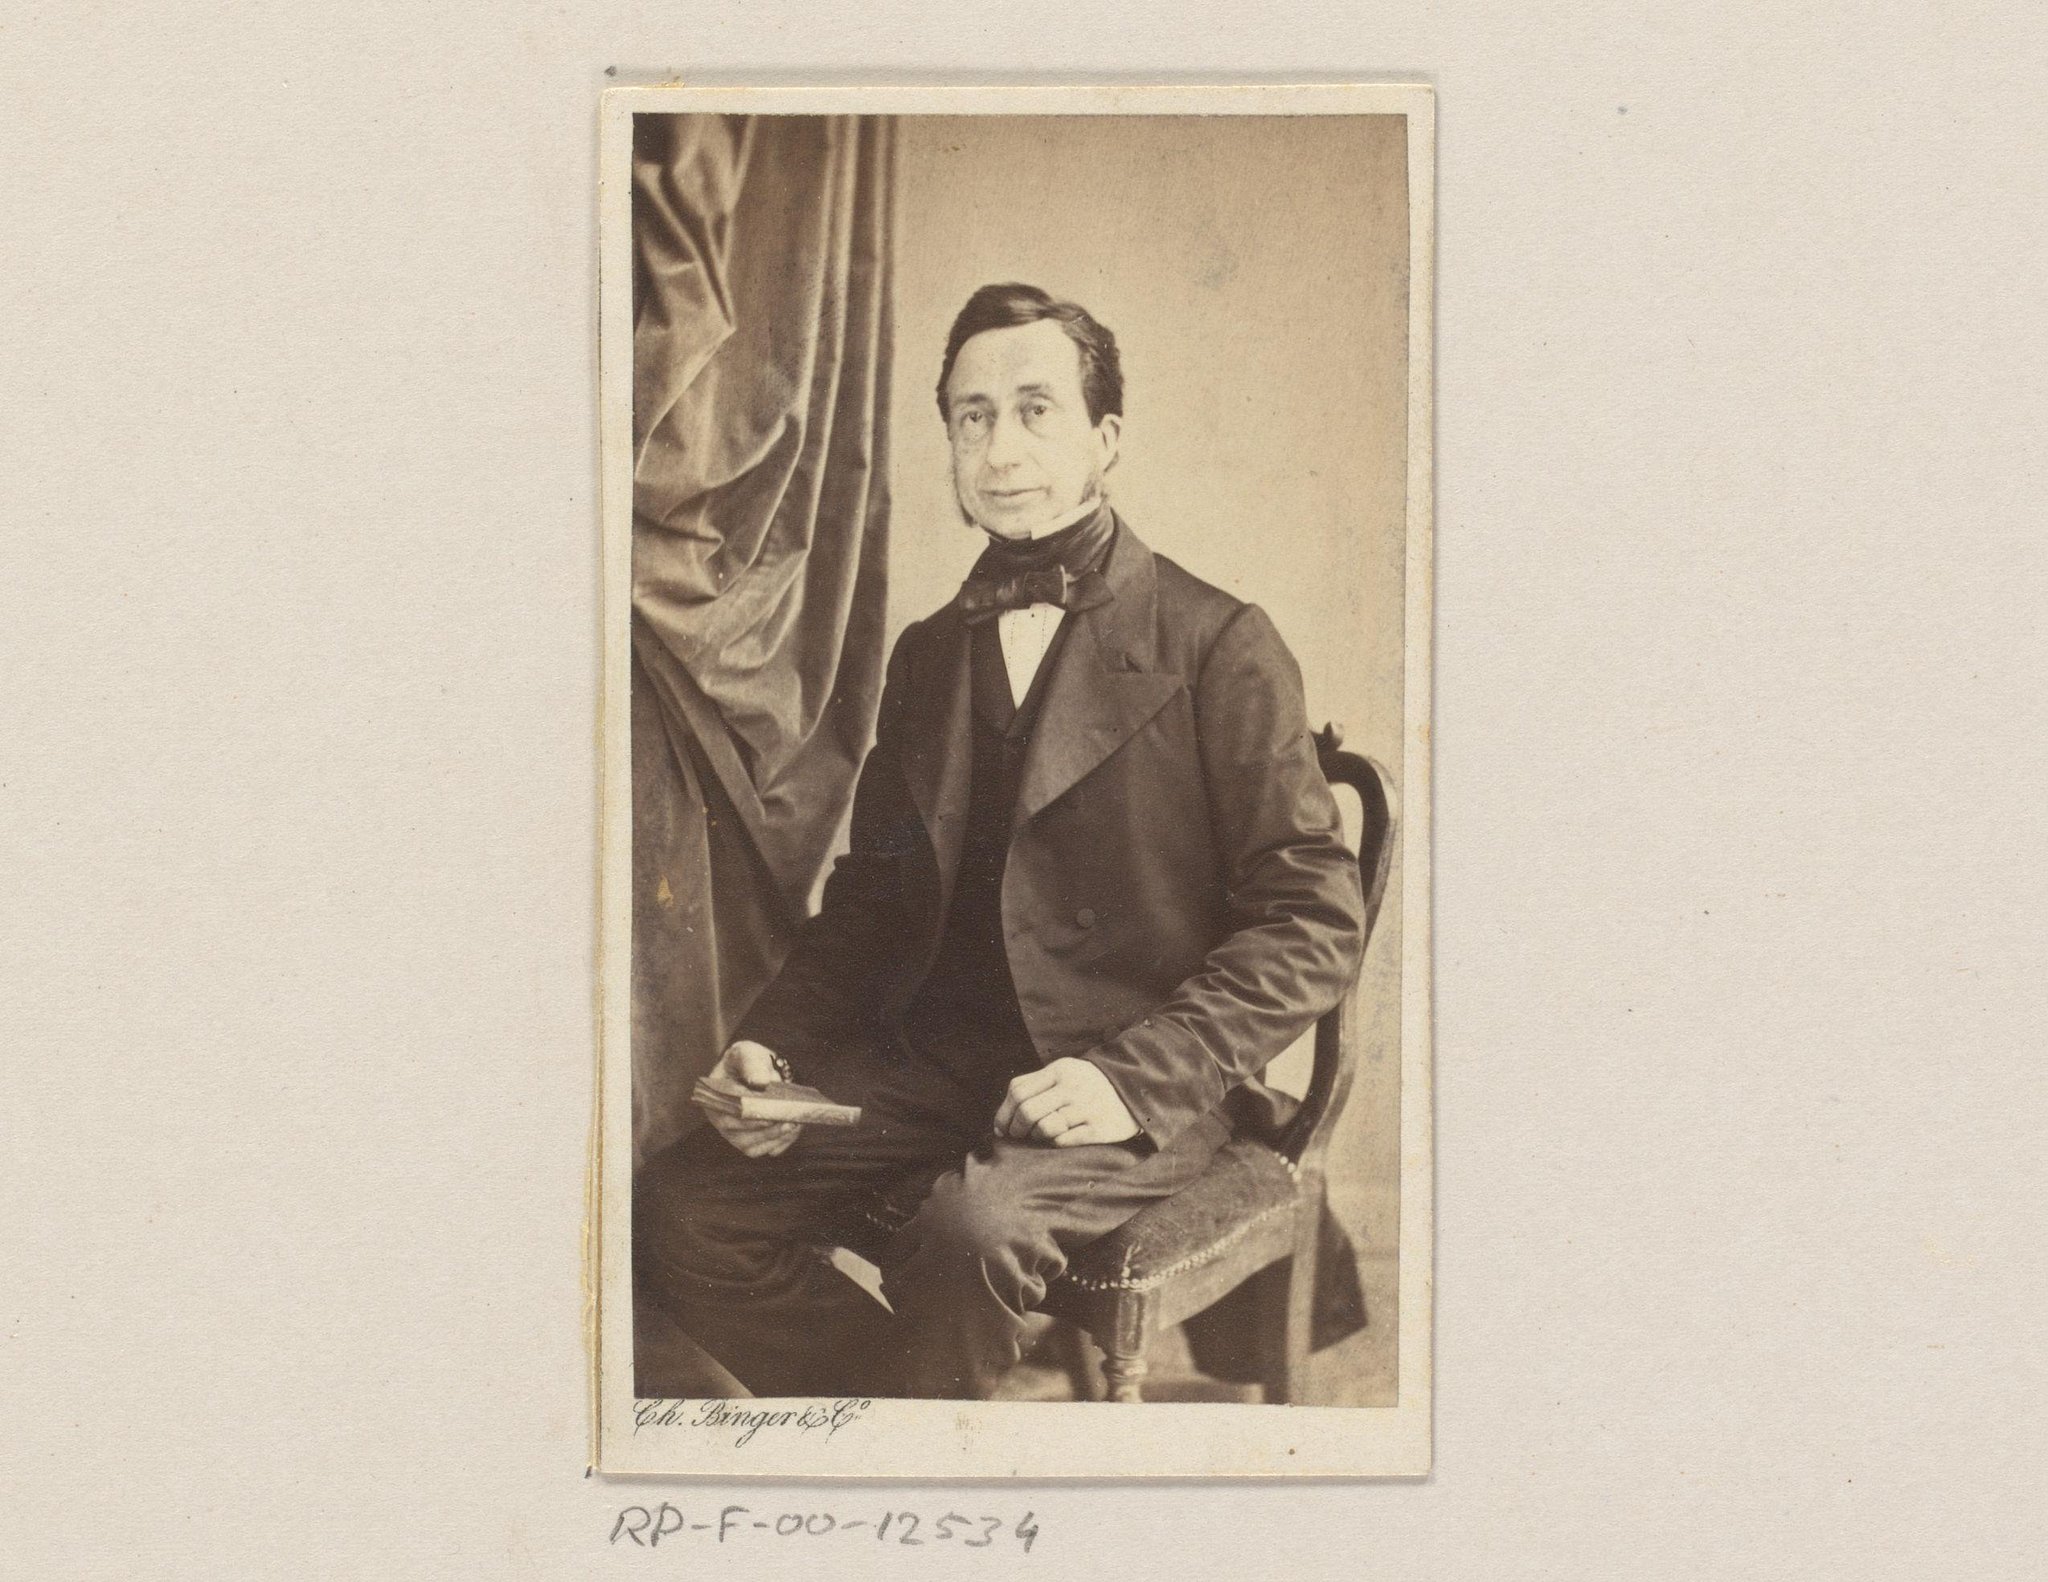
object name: carte de visite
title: Portret van predikant Jan Hendrik Michelsen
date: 1862-1882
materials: cardboard, paper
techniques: albumen print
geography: haarlem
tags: amsterdam, historical persons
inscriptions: address: ‘Zylstraat, HAARLEM.’